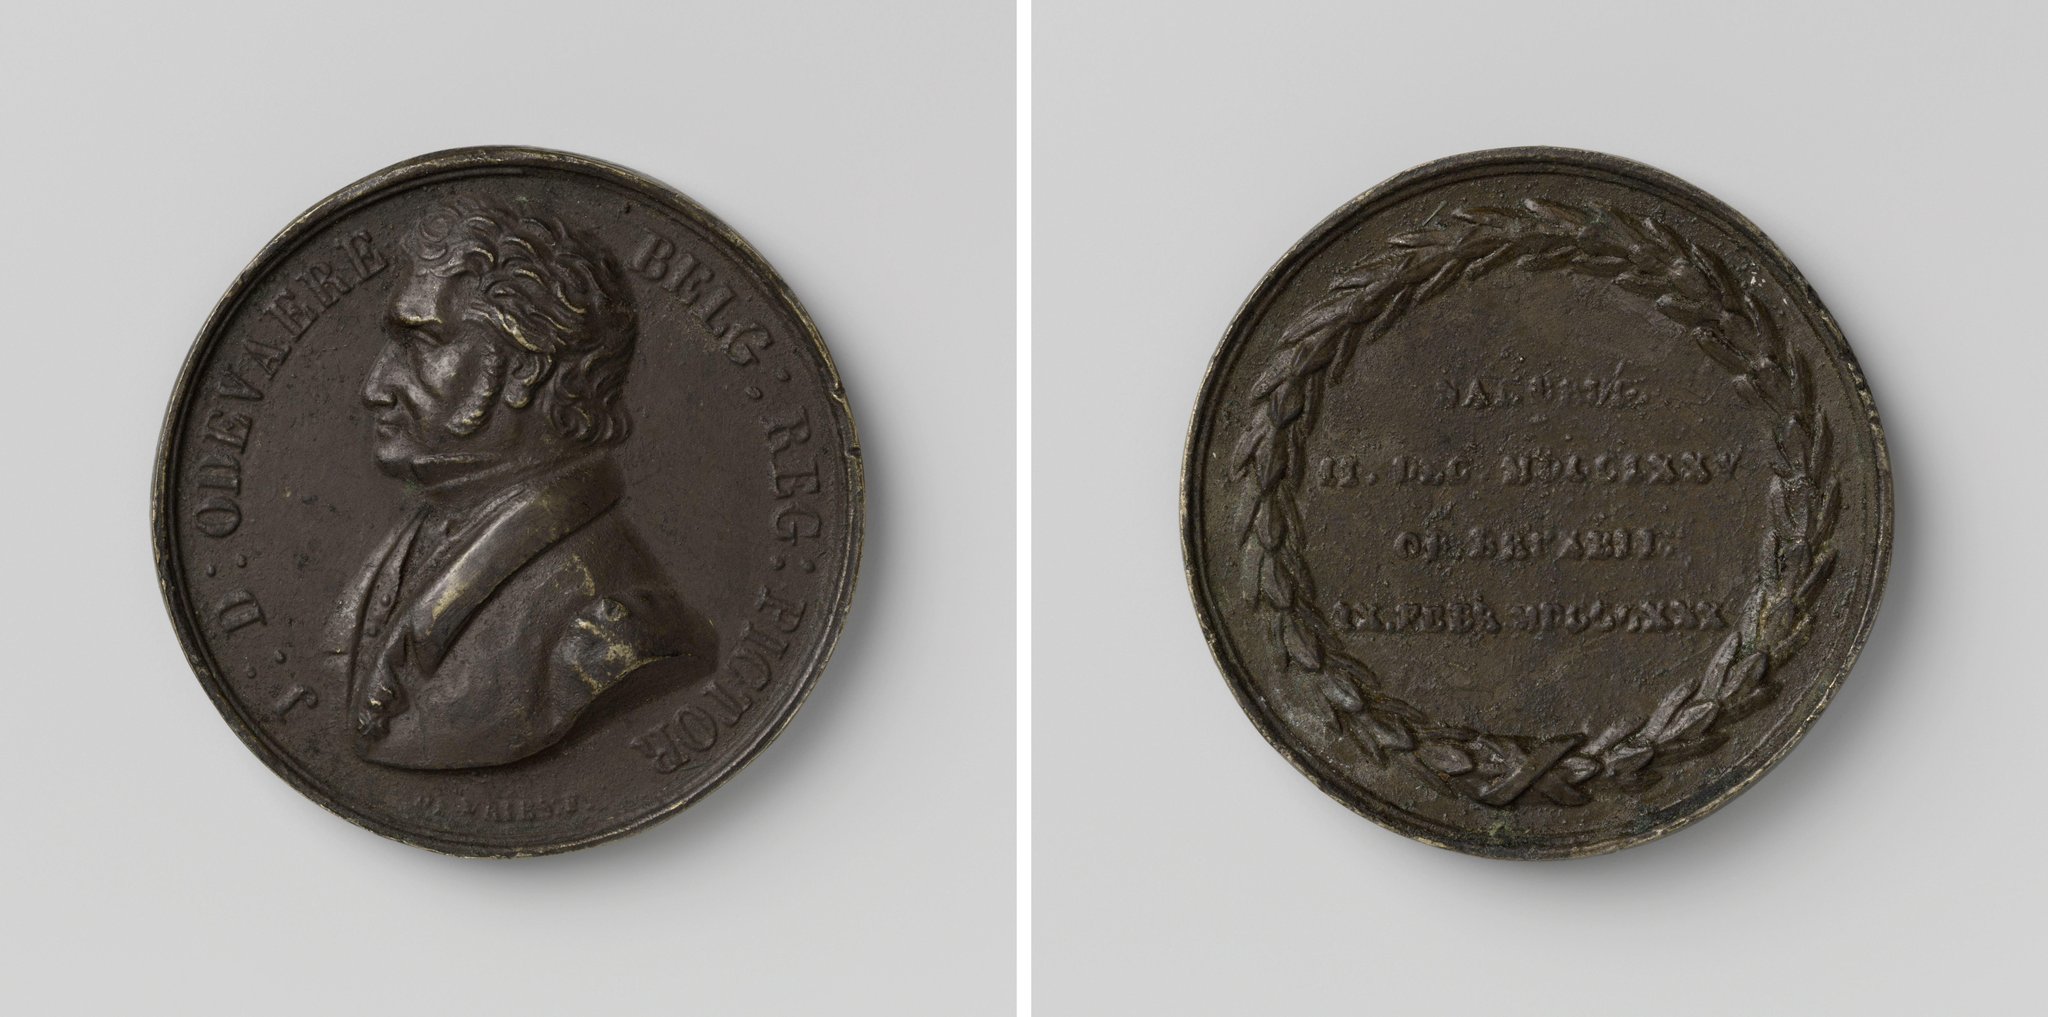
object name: copy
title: Overlijden van J.D. Odevaere, Belgisch schilder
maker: de vries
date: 1830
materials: silver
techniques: striking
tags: bruges, brussels, print maker, joseph-denis odevaere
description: Zilveren penning. Voorzijde: borststuk man binnen omschrift. Keerzijde: opschrift binnen lauwerkrans